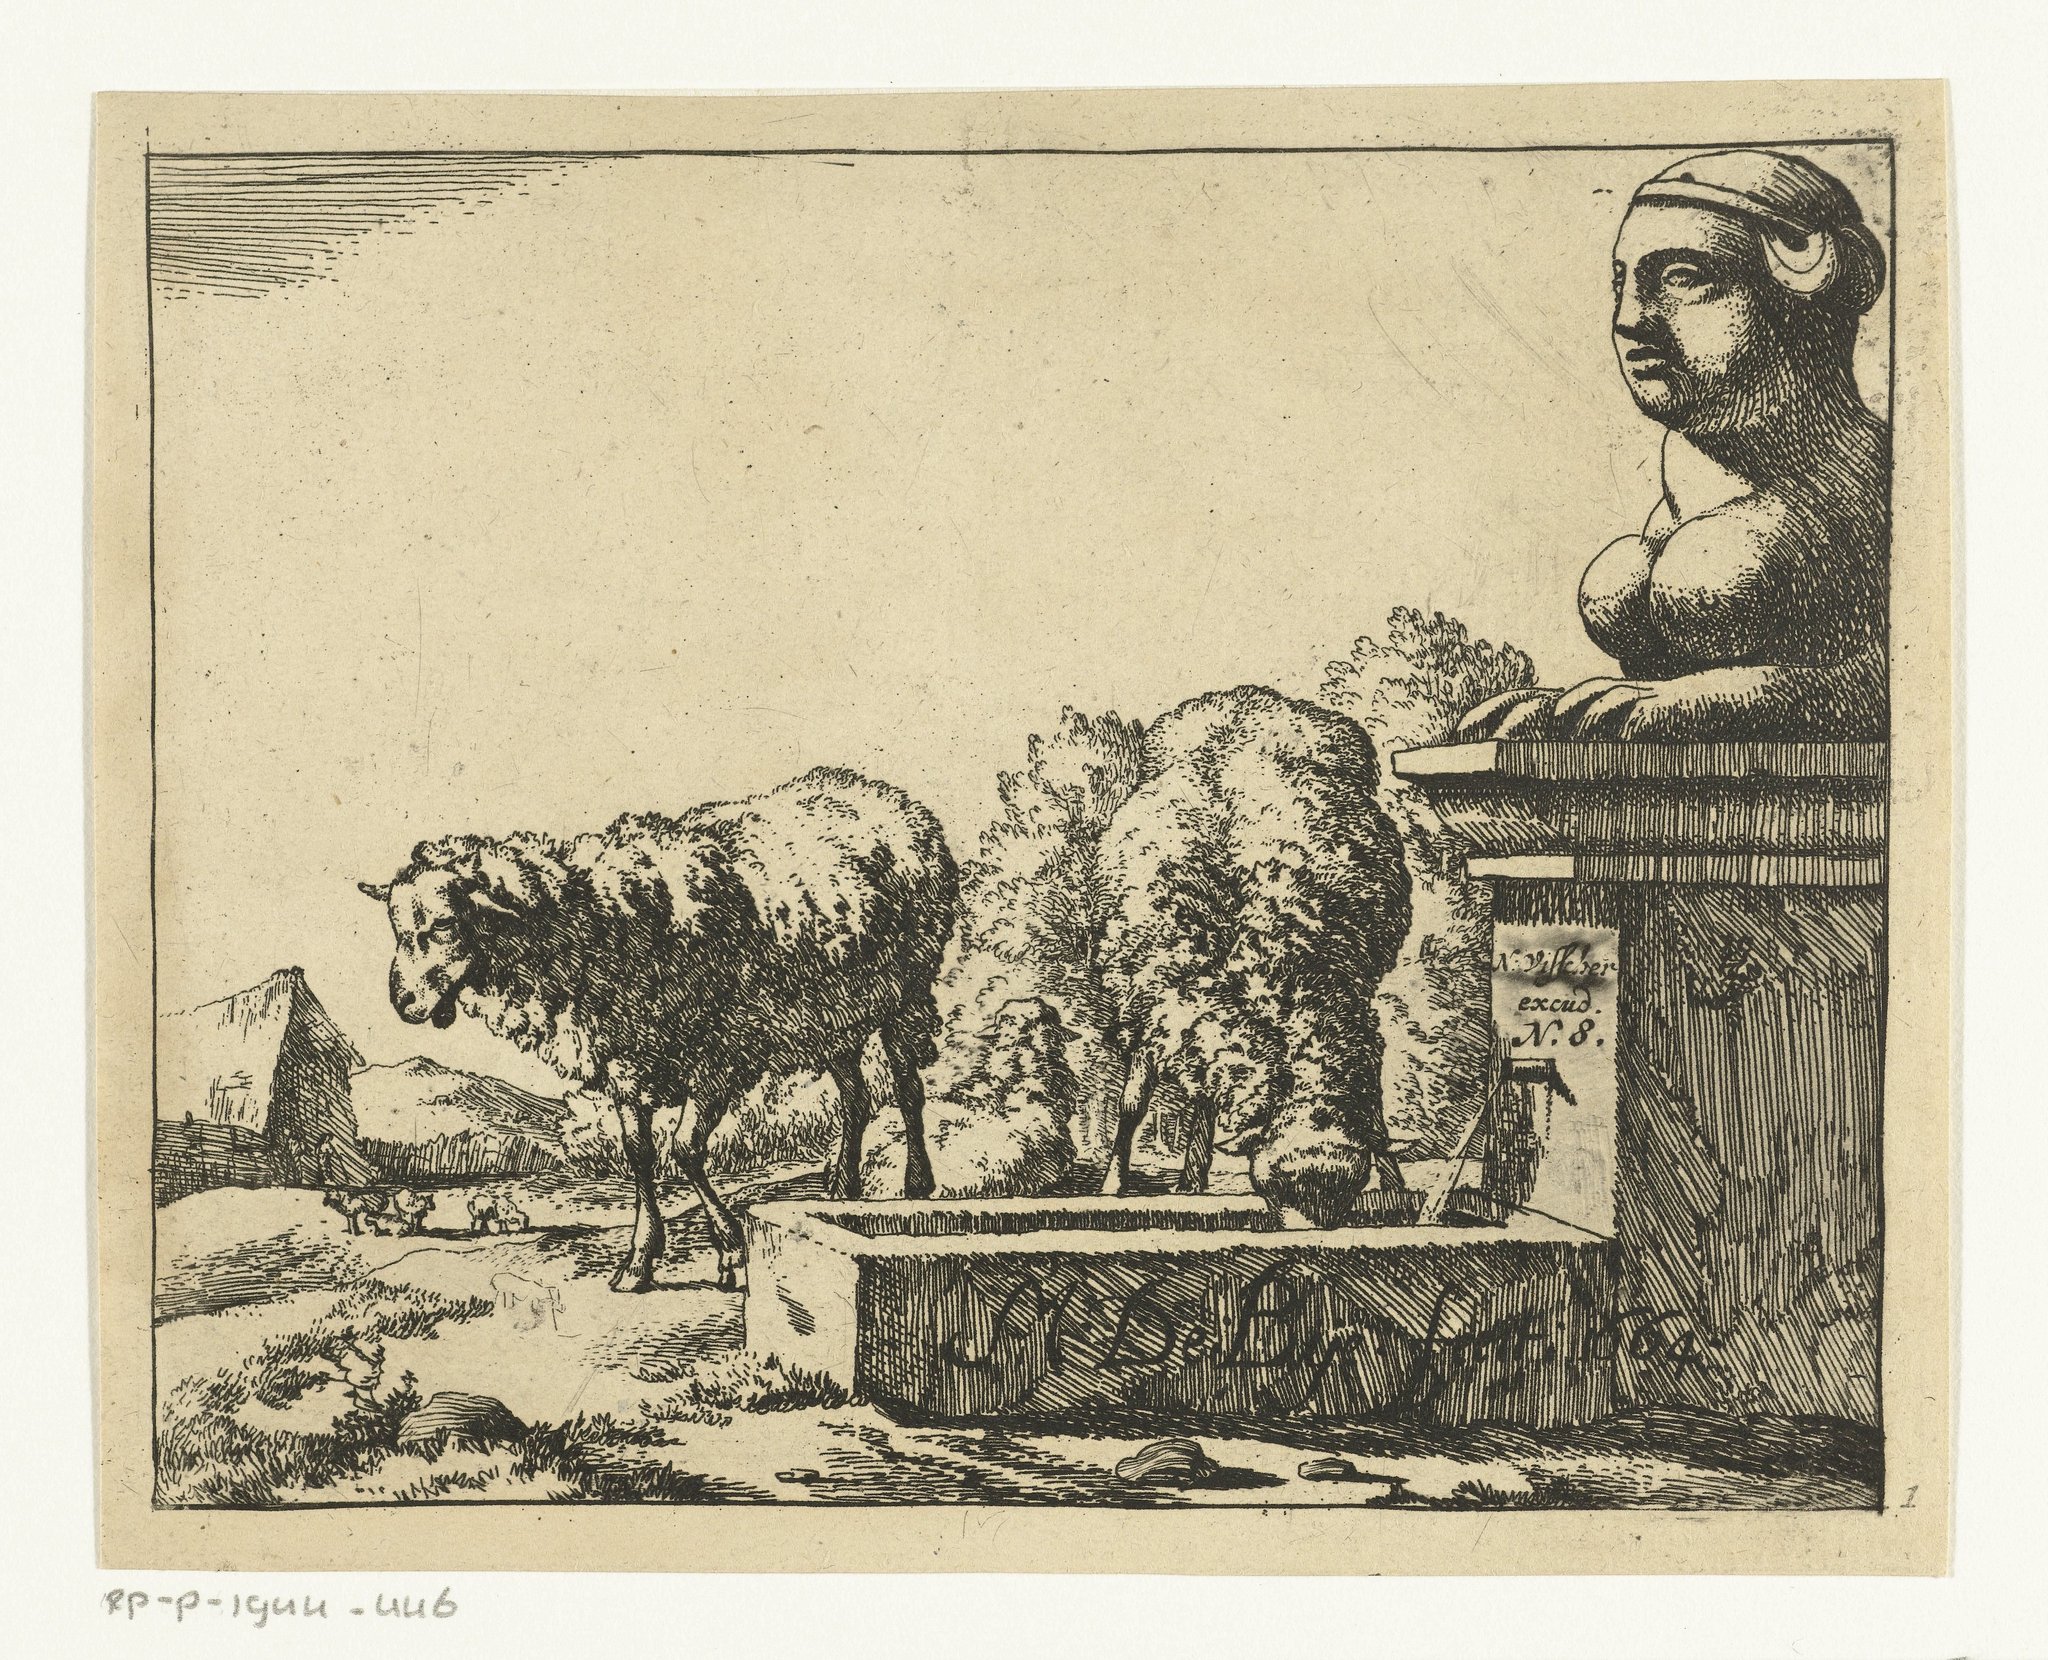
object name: print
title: Twee schapen bij drinkbak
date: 1664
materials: paper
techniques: etching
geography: the hague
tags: sheep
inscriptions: collector's mark: Lugt 2228